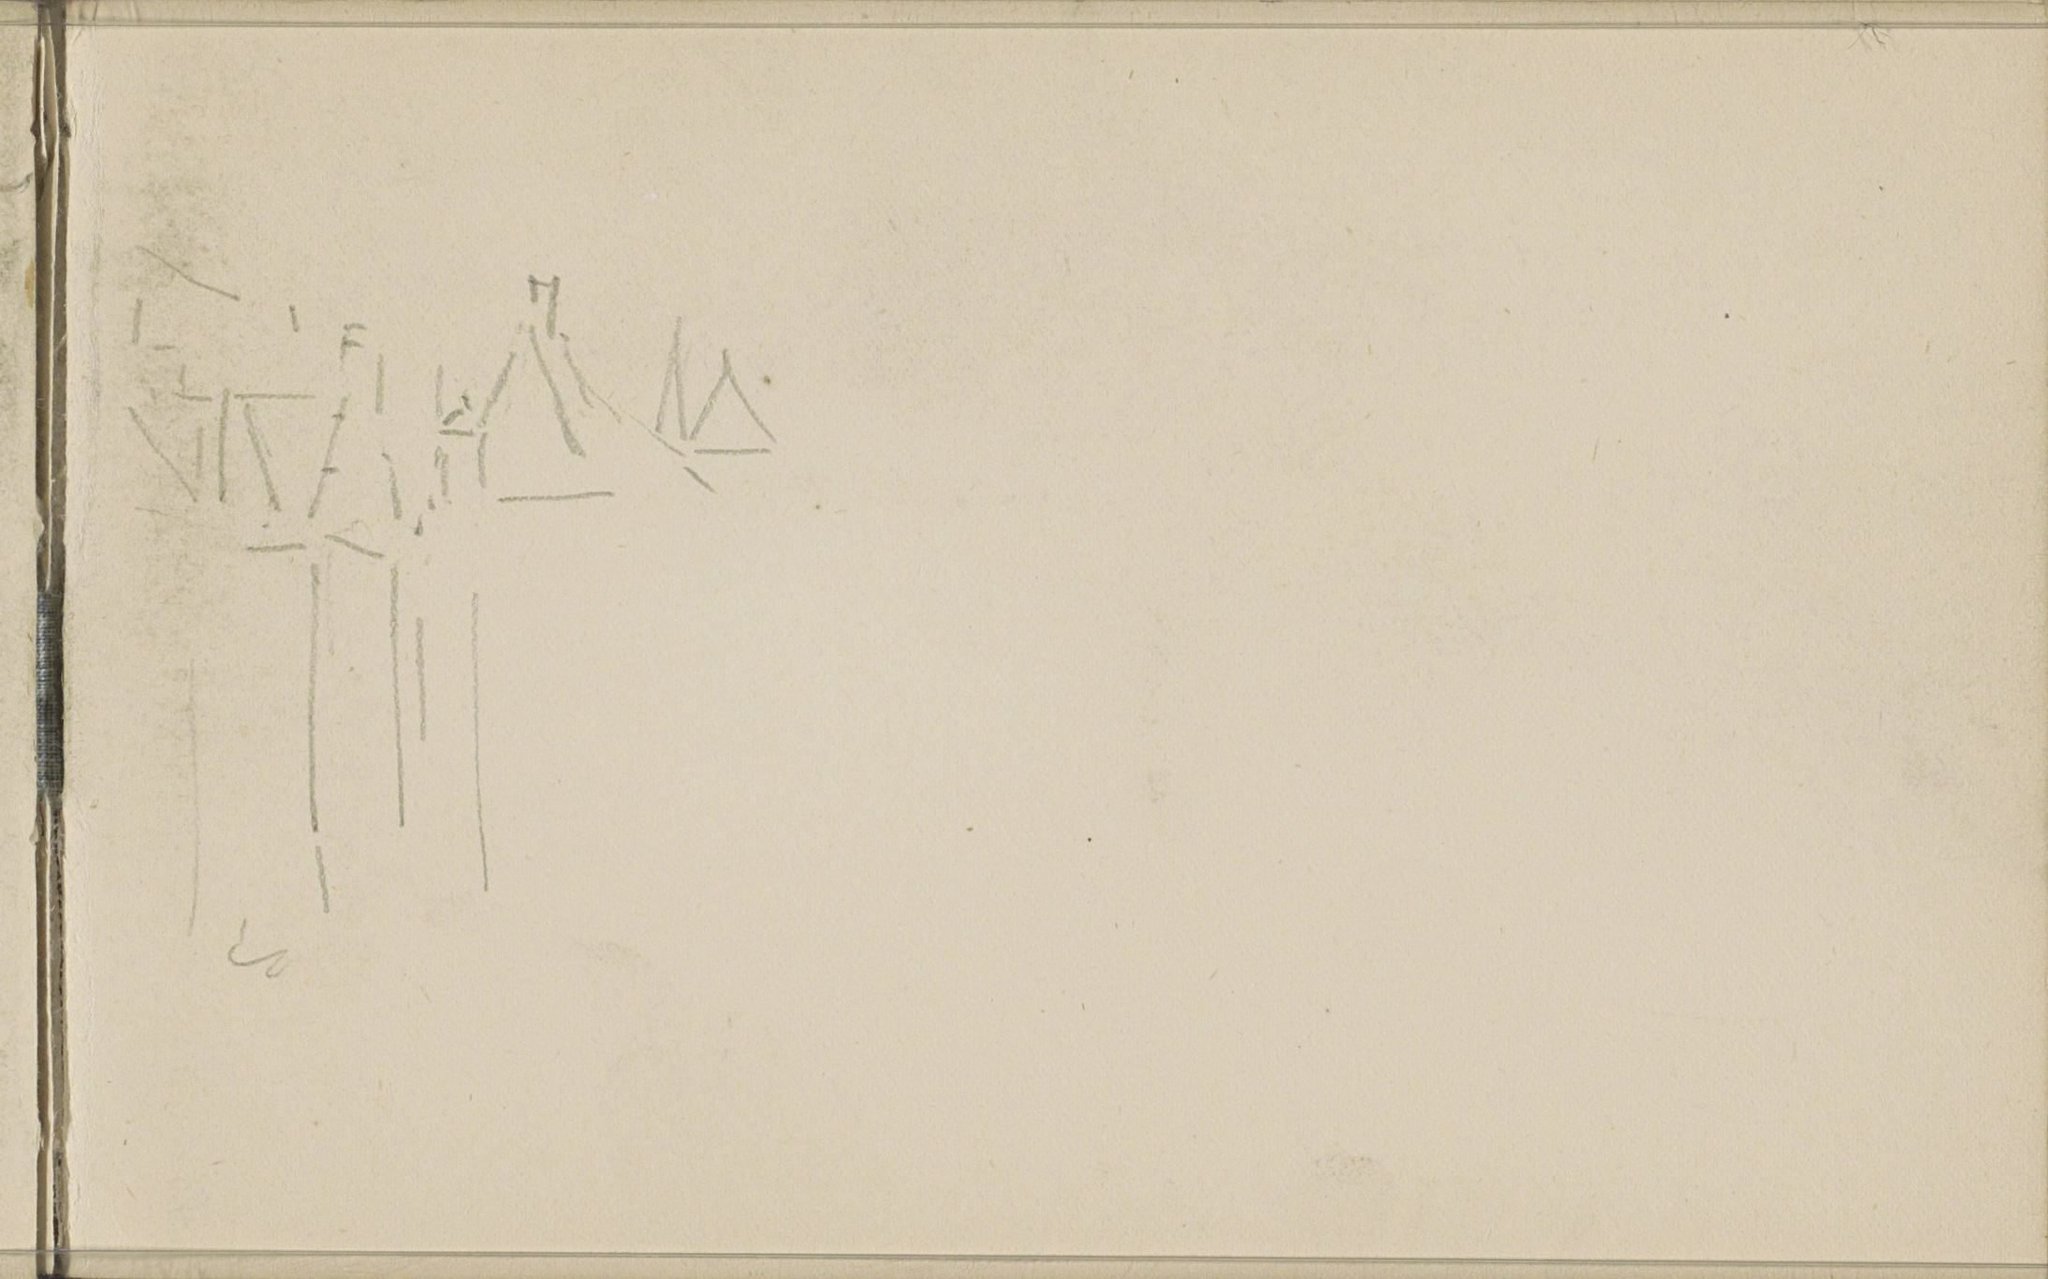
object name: sketchbook leaf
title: Studieblad, mogelijk met gebouwen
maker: johan antonie de jonge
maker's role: draughtsman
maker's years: 1864-1927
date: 1909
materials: paper, pencil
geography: south holland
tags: civic architecture; edifices; dwellings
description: Studieblad, mogelijk met gebouwen. Blad 25 recto uit een schetsboek met 31 bladen.